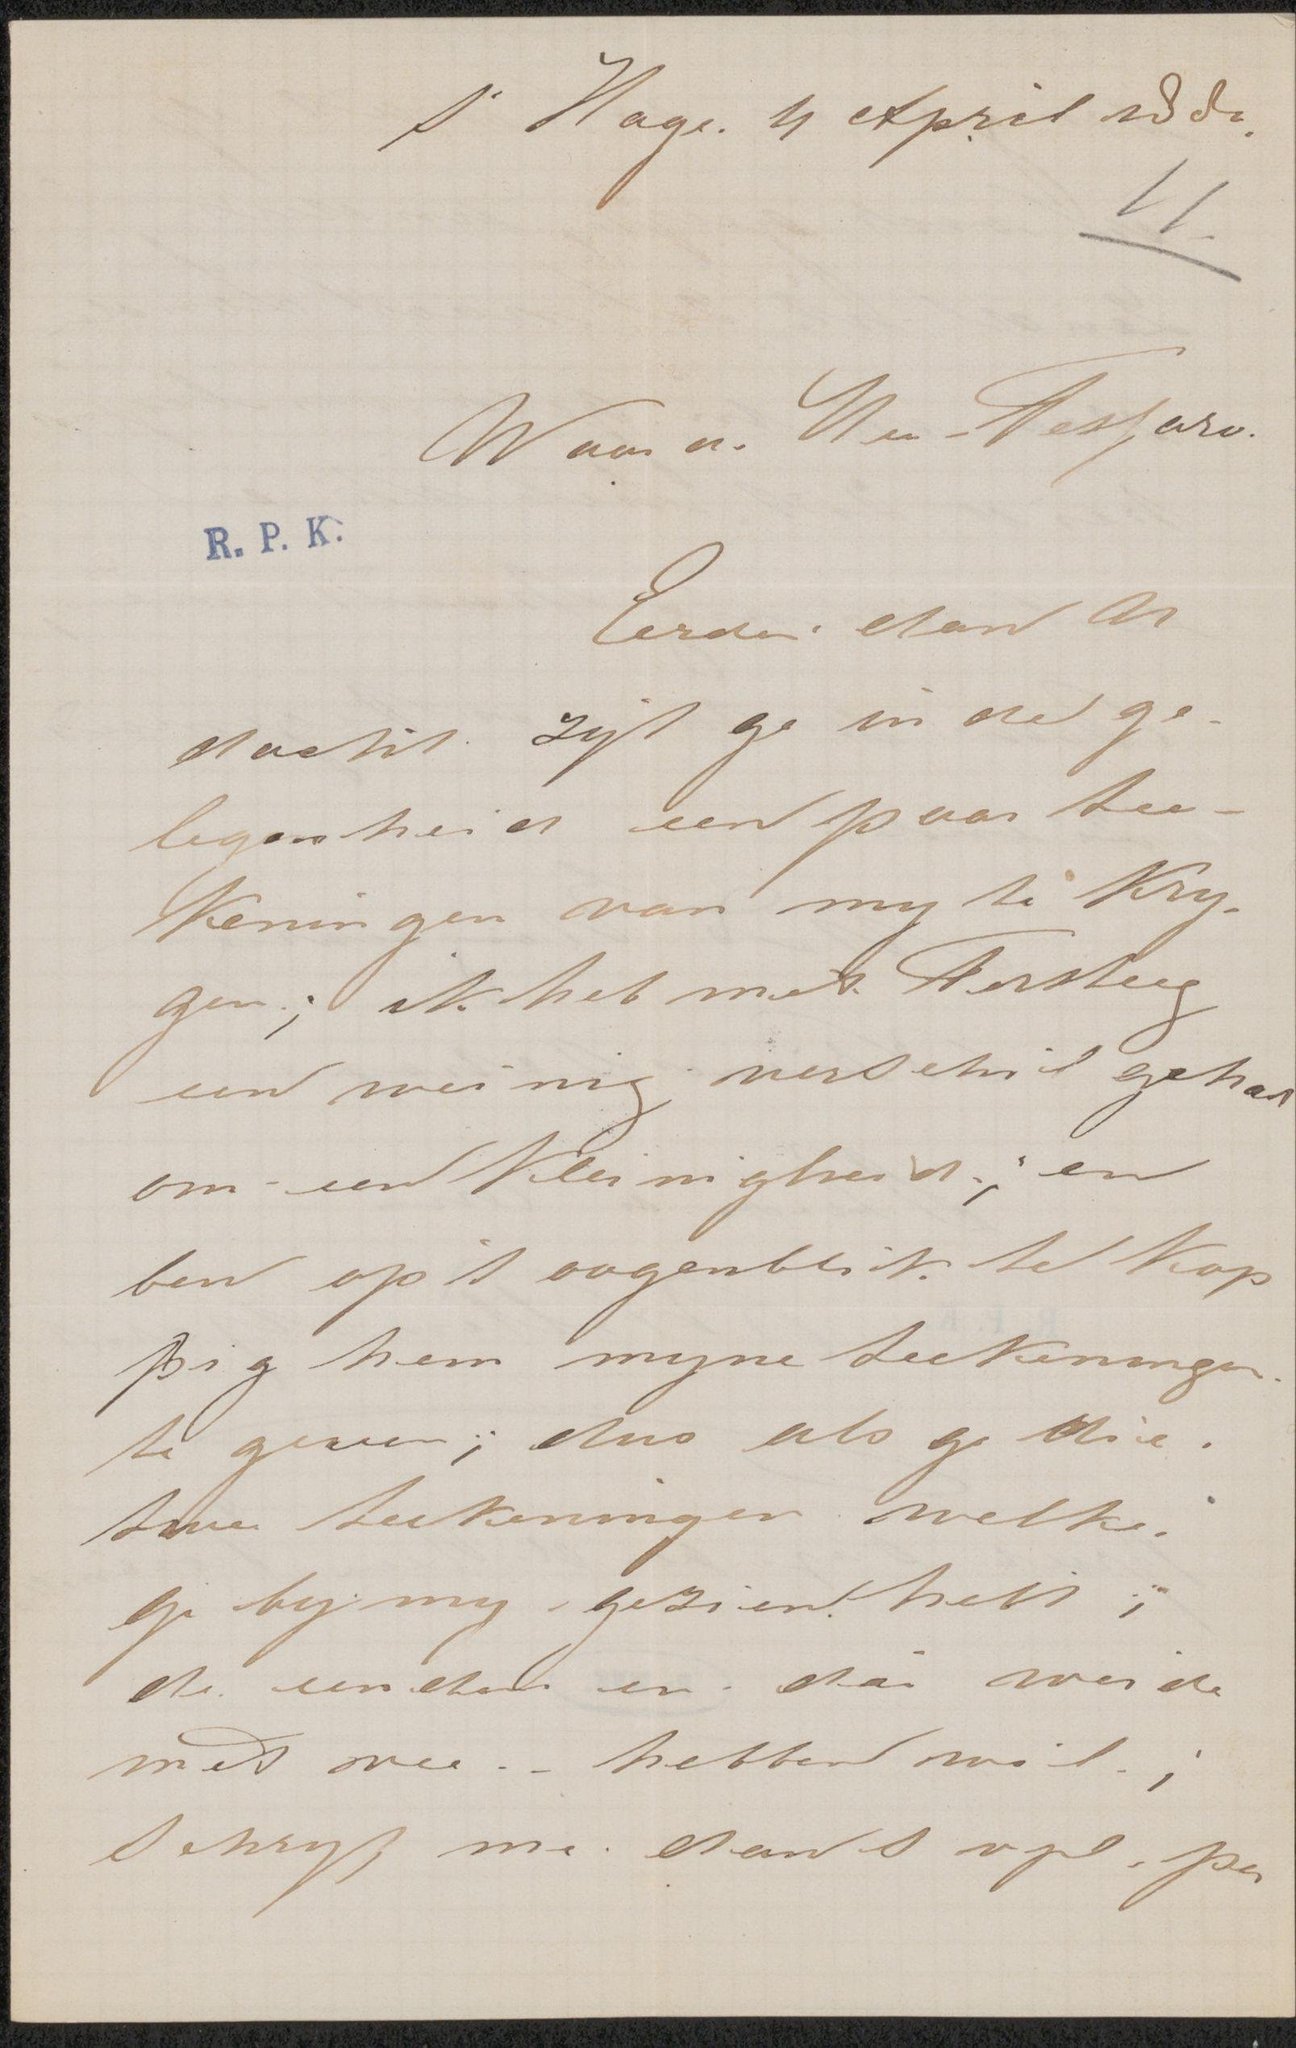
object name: letter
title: Brief aan Filippo Tessaro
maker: willem maris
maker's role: draughtsman, painter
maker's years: 1844-1910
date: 1880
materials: ink, paper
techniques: pen, writing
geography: the hague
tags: amsterdam, hermanus gijsbertus tersteeg, art trade, art shop, drawing, money, london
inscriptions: collector's mark: Lugt 2233, collector's mark: Lugt 2228